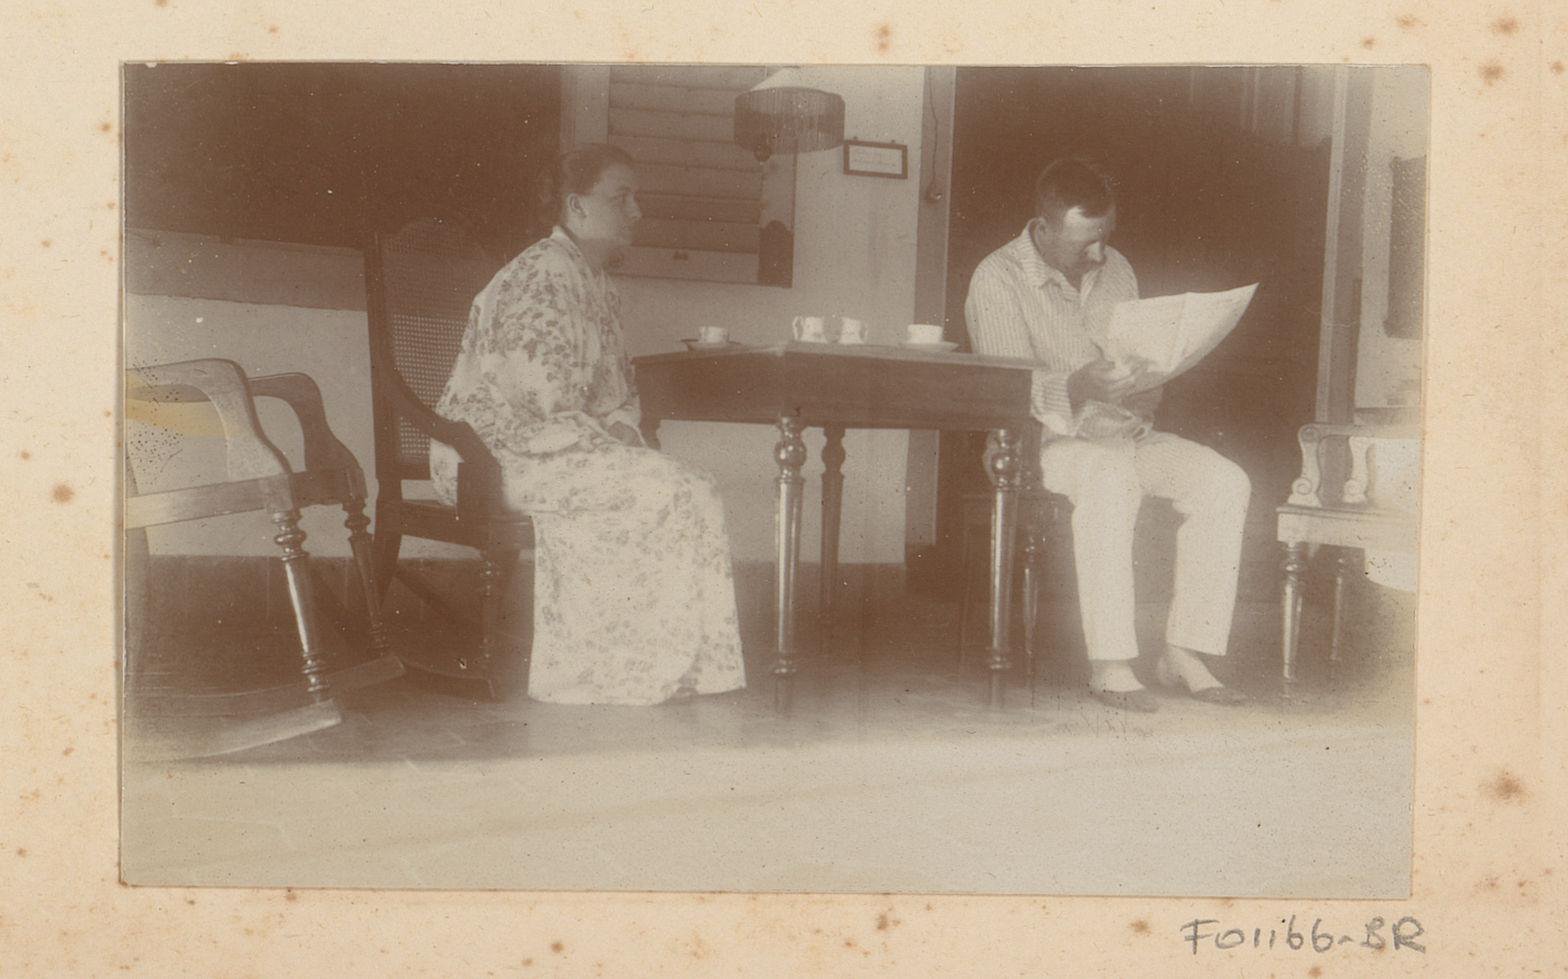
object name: album leaf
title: Man en vrouw op veranda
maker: Anonymous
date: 1880-1910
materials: photographic support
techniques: daylight paper print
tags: adult woman, adult man, historical persons, loggia, verandah, porch, dutch east indies, the